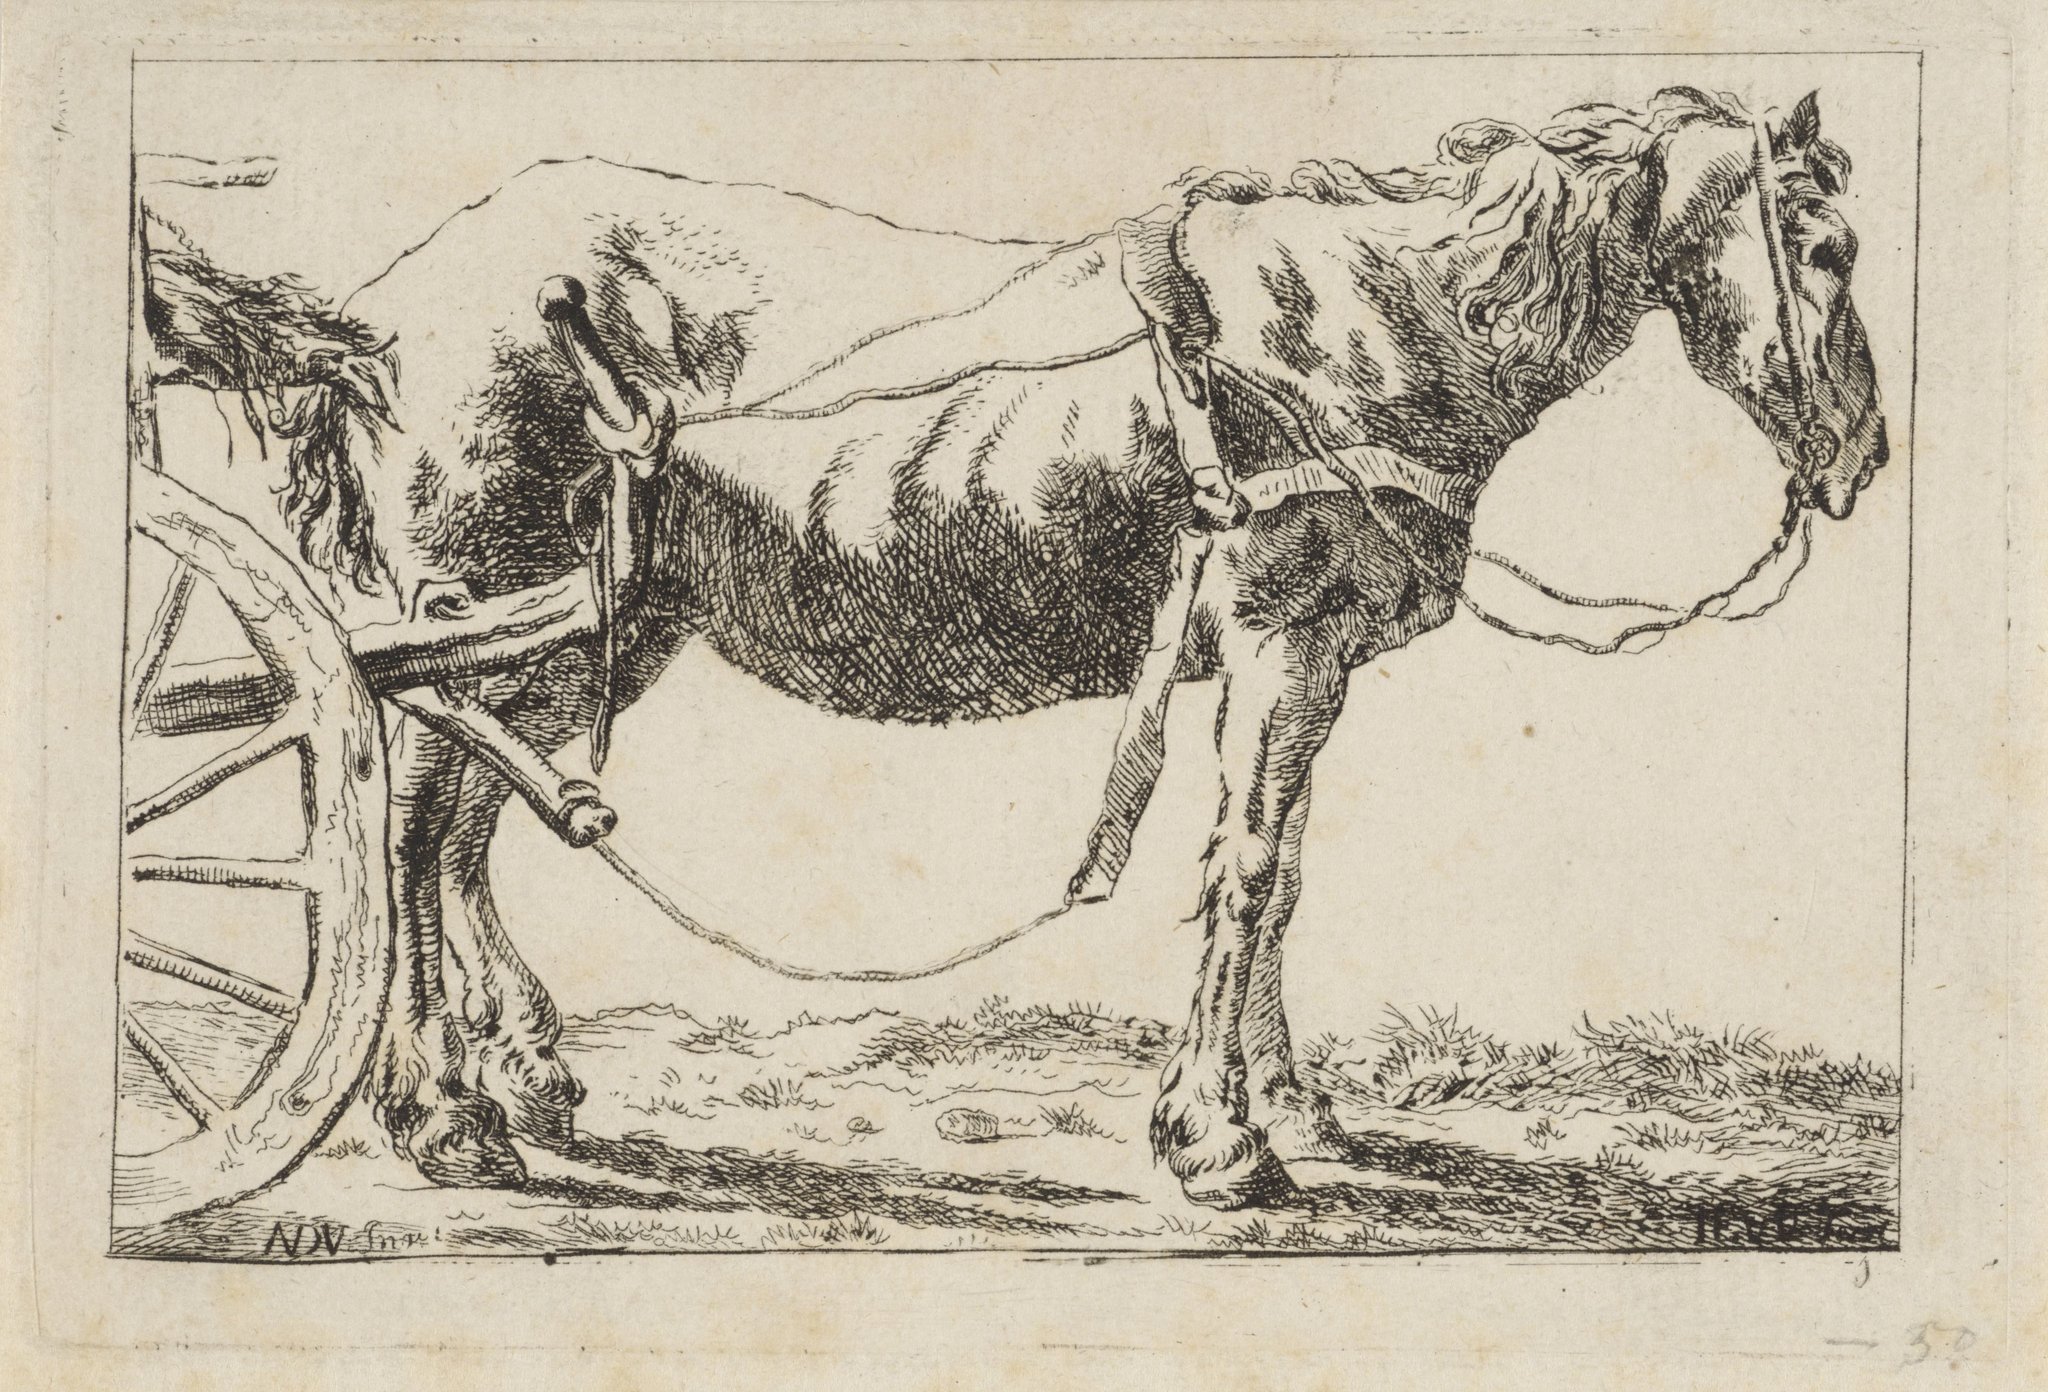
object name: print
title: Paard voor een kar ingespannen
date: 1772-1840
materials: paper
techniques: etching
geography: haarlem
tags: horse, (farm) wagon, freight wagon, cart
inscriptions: collector's mark: Lugt 2228